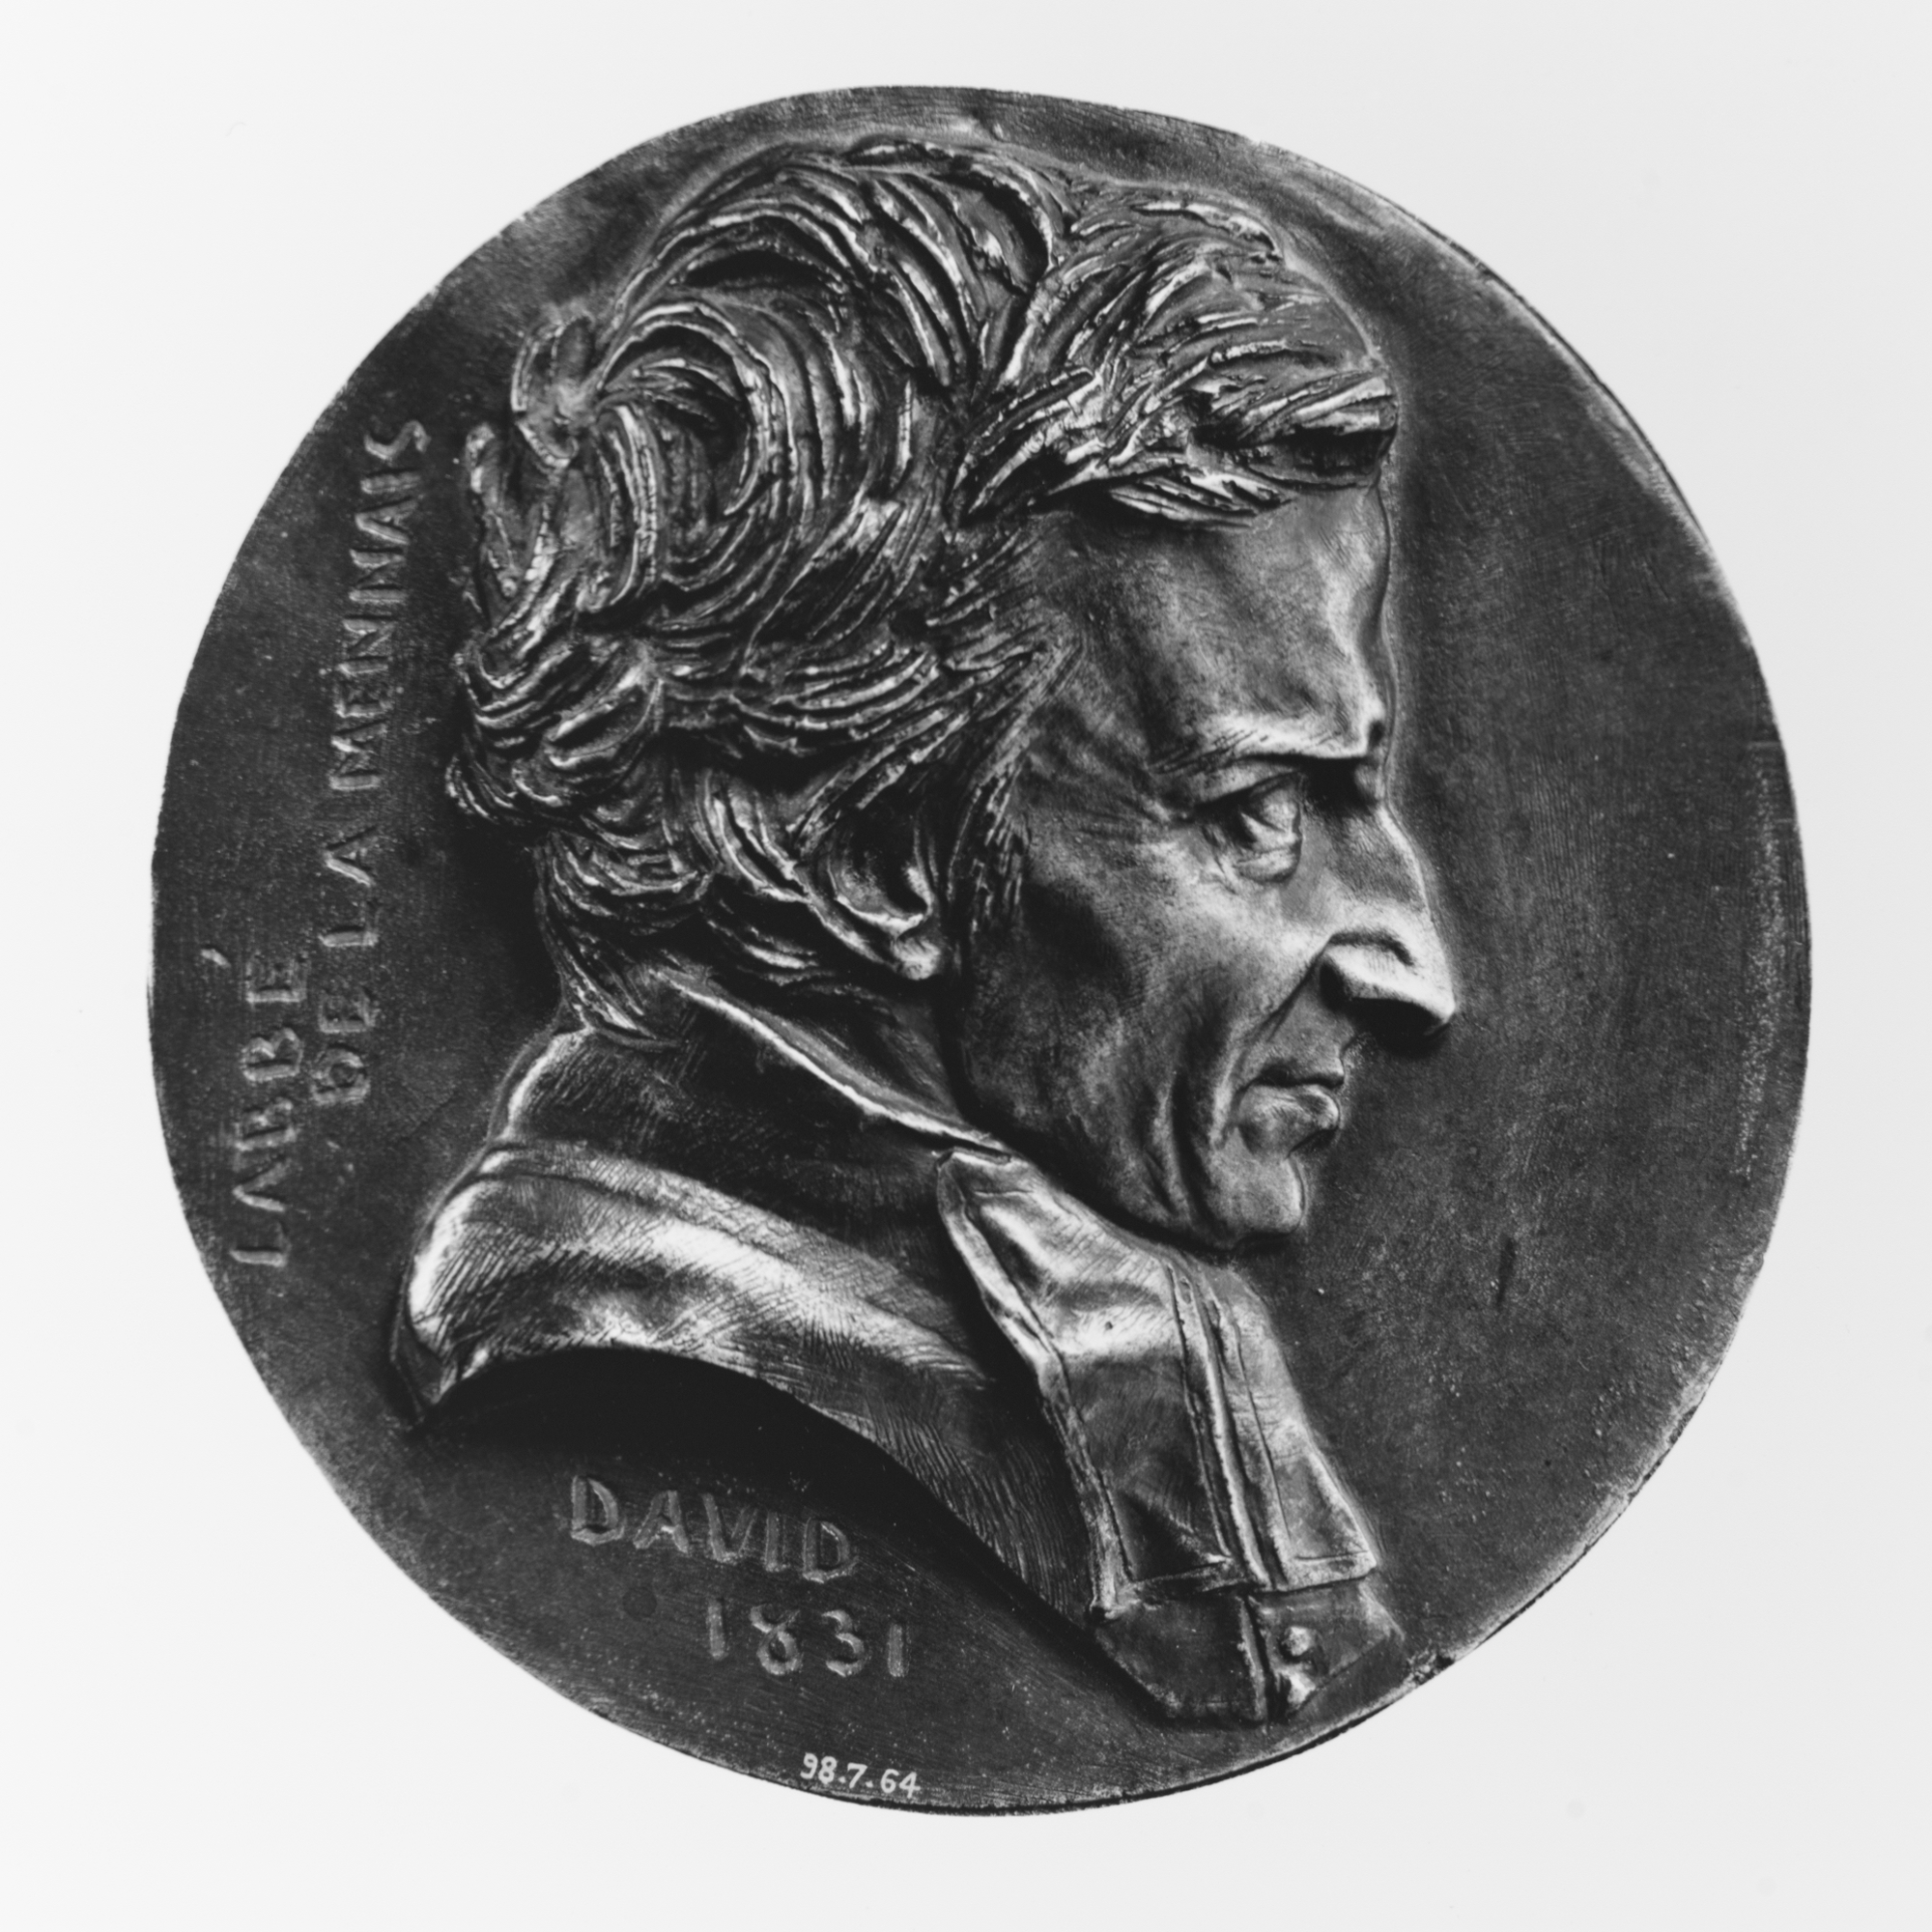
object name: medallion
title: L'Abbé (Felicité Robert) de Lamennais (1782–1854), French ecclesiastic and theorist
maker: pierre jean david d'angers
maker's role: artist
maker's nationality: french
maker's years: 1788-1856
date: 1831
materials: bronze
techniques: casting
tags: men,profiles